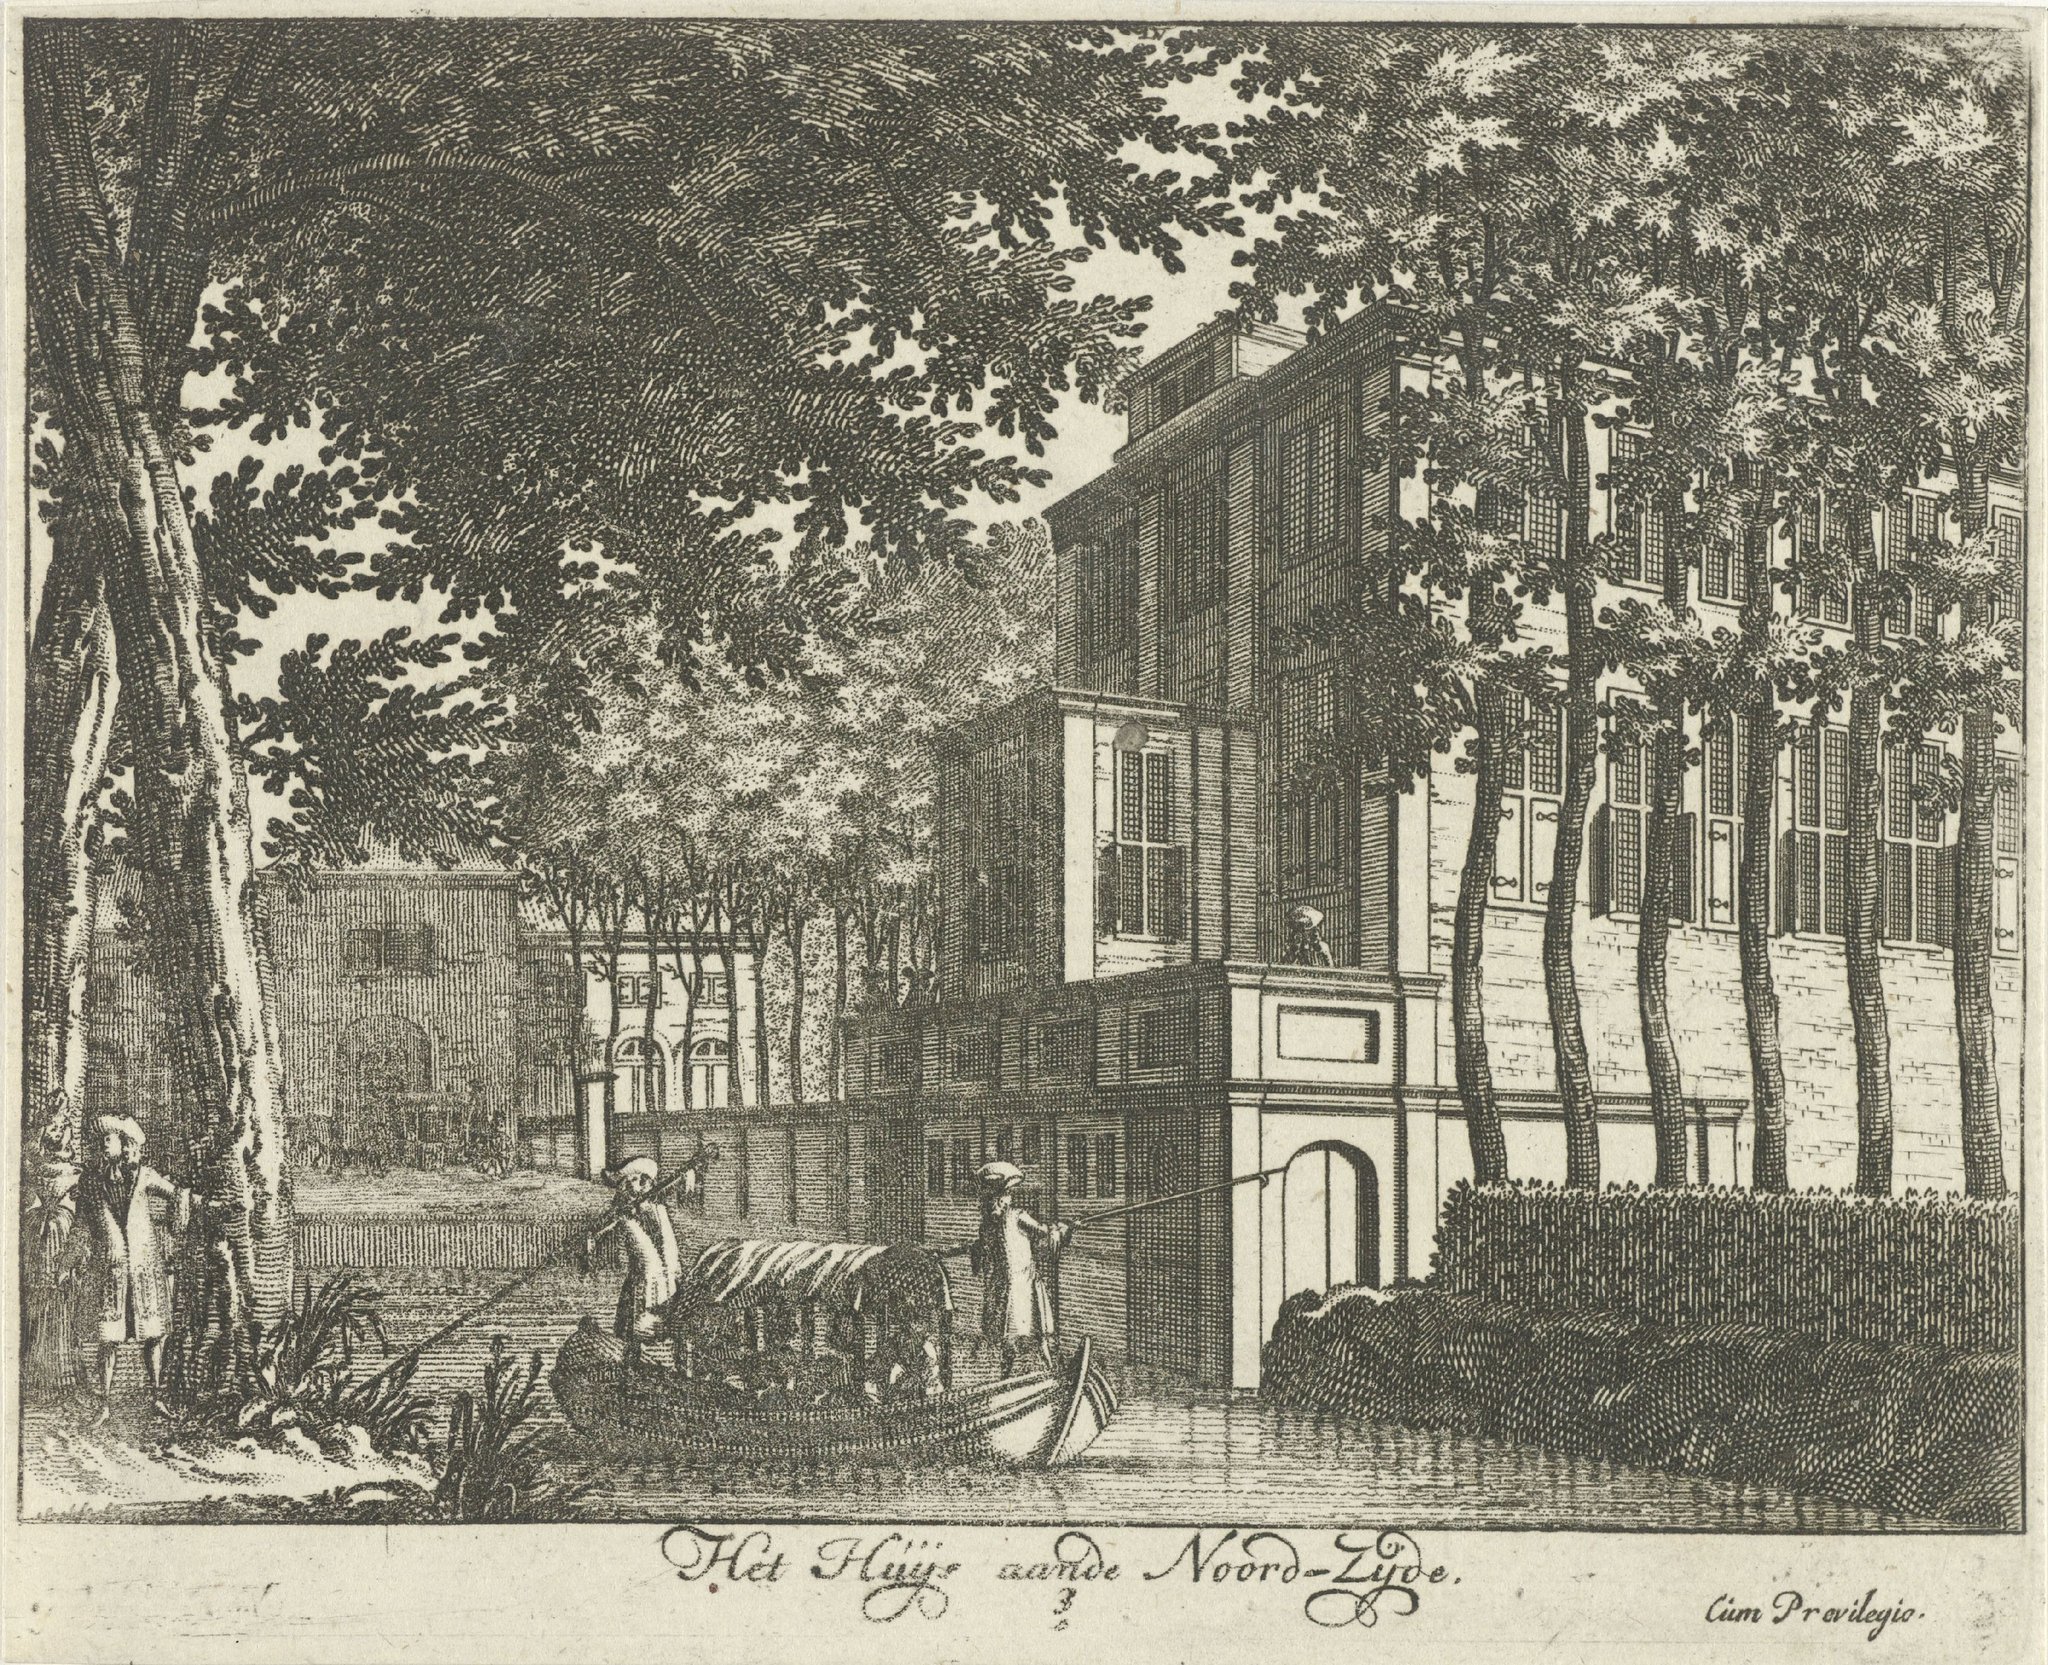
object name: print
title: Het Huijs aande Noord-Zijde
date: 1725-1747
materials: paper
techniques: etching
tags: palace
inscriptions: collector's mark: Lugt 2228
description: Gezicht op de noordzijde van Paleis Soestdijk met op de voorgrond twee staande figuren in een boot op het water. De prent maakt deel uit van een serie met zestien gezichten op Paleis Soestdijk en het bijbehorende landgoed.